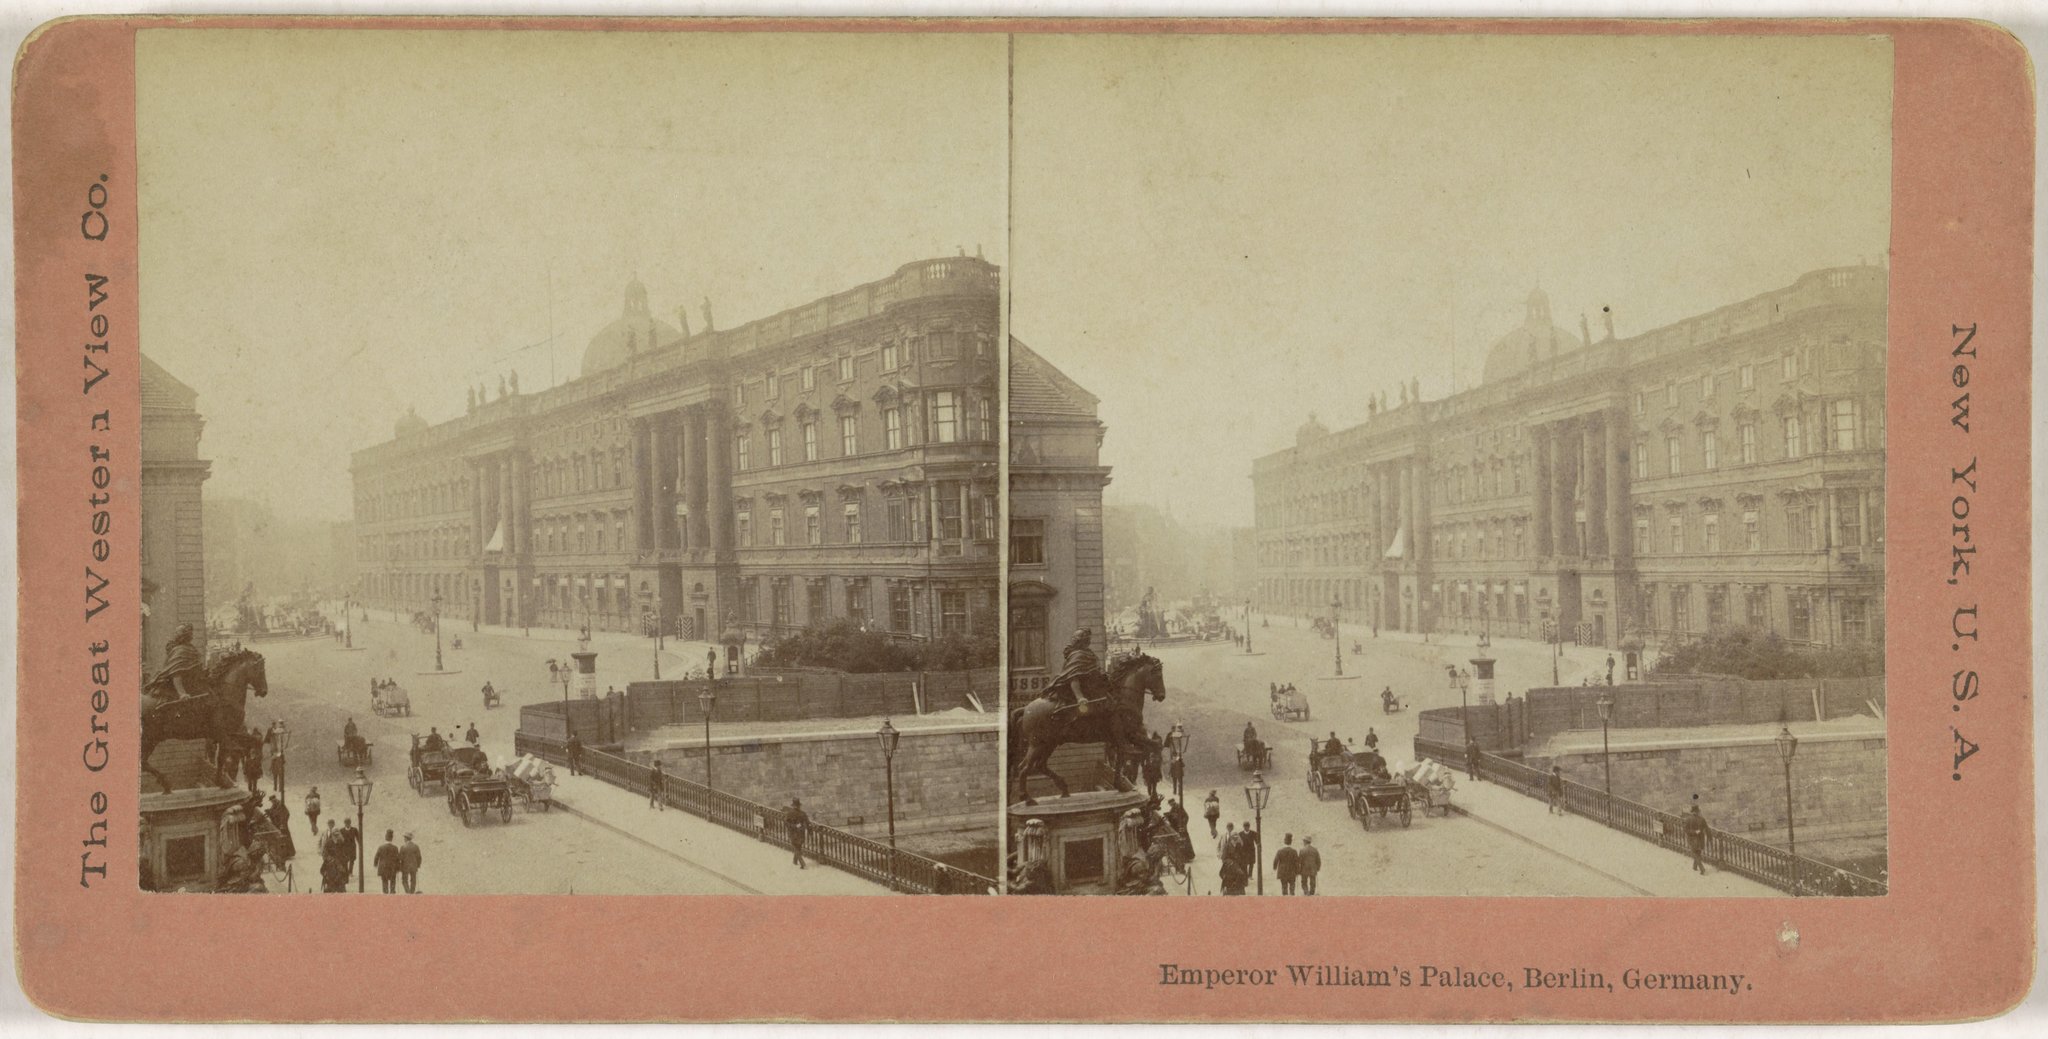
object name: stereograph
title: Paleis van Keizer Wilhelm te Berlijn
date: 1890-1910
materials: cardboard, paper, photographic support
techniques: albumen print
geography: new york city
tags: berlin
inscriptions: number: ‘00000’